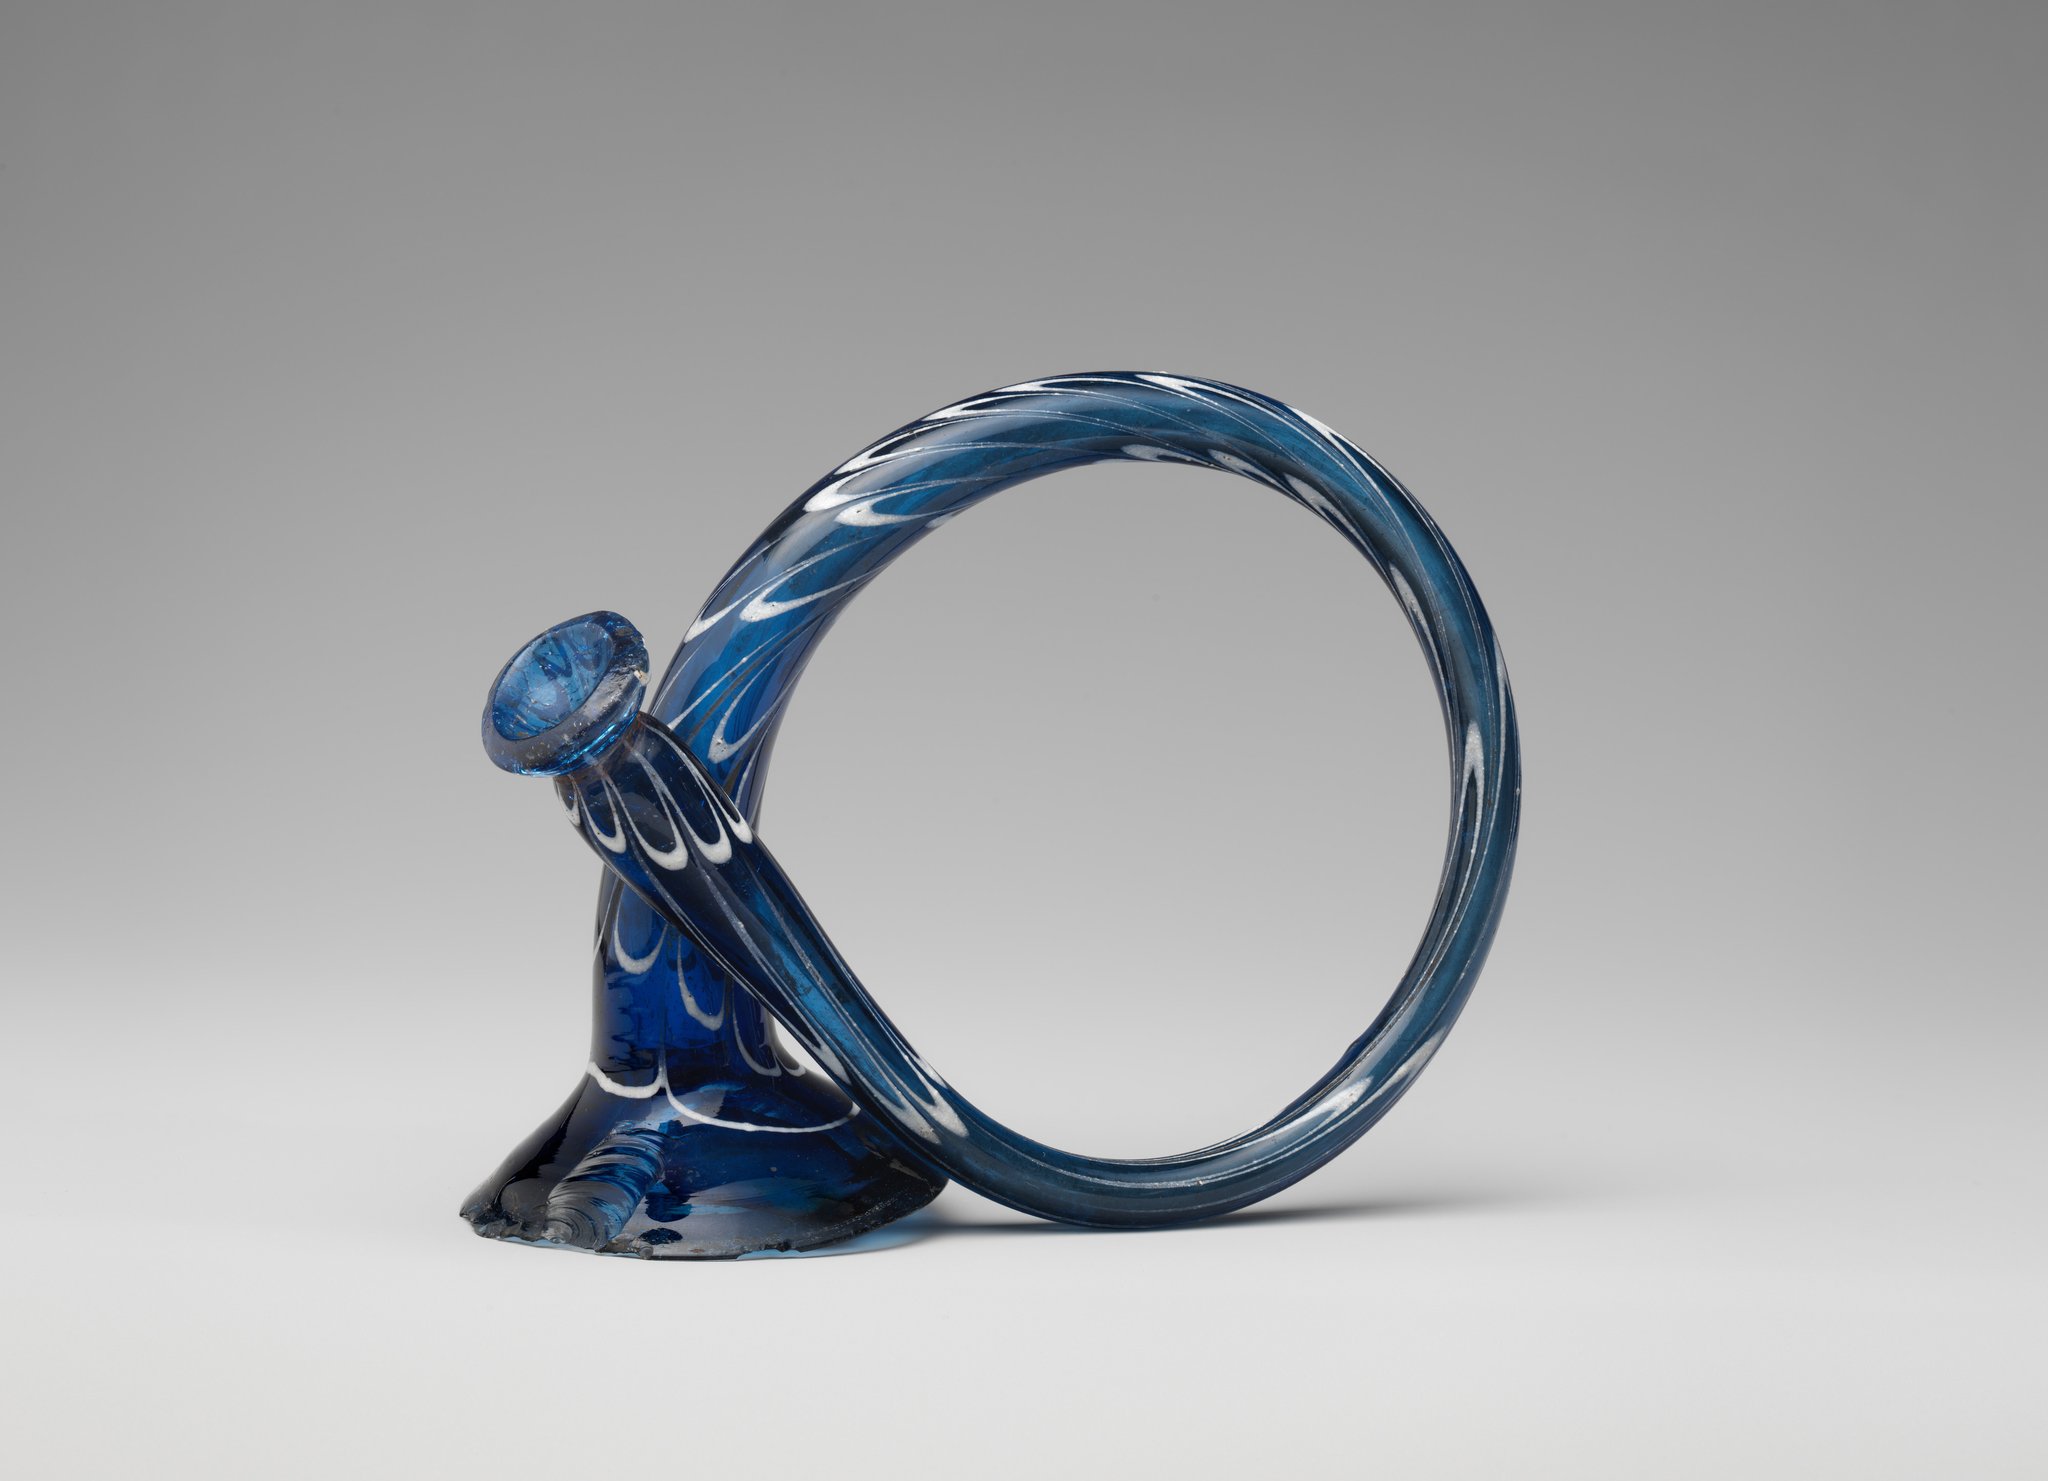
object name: horn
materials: glass